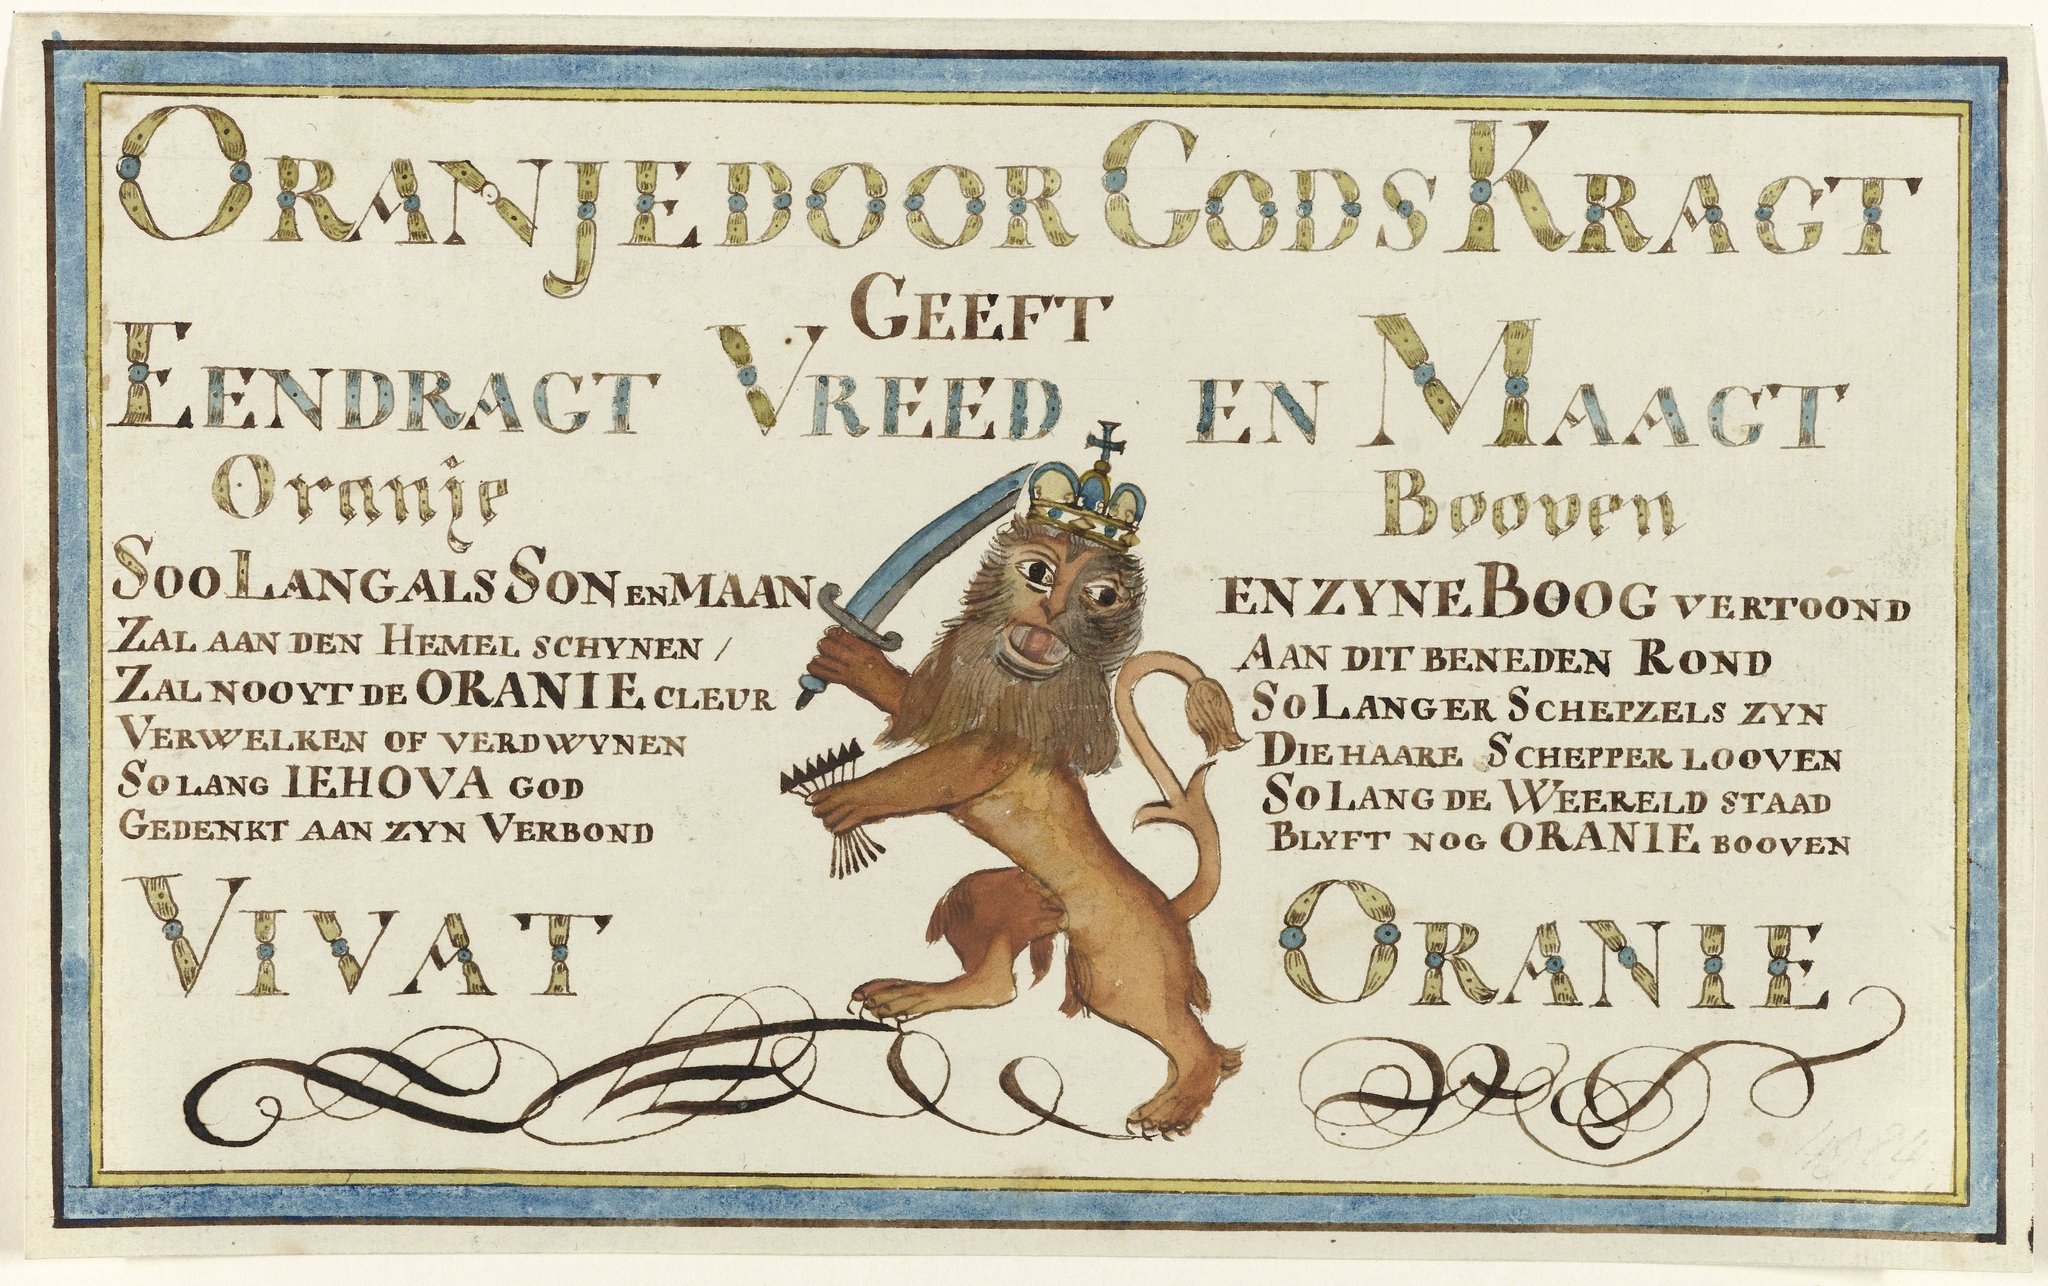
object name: calligraphy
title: Kalligrafie op de eendracht door Oranje, 1787-1788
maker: Anonymous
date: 1787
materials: paper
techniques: calligraphy, writing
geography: northern netherlands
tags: calligraphy, netherlands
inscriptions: collector's mark: Lugt 2228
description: Kalligrafie op de eendracht in het land onder Oranje en Gods zegen, 1787. De Nederlandse Leeuw met zwaard en pijlenbundel, aan weerszijden versregels, onderaan: Vivat Oranje.